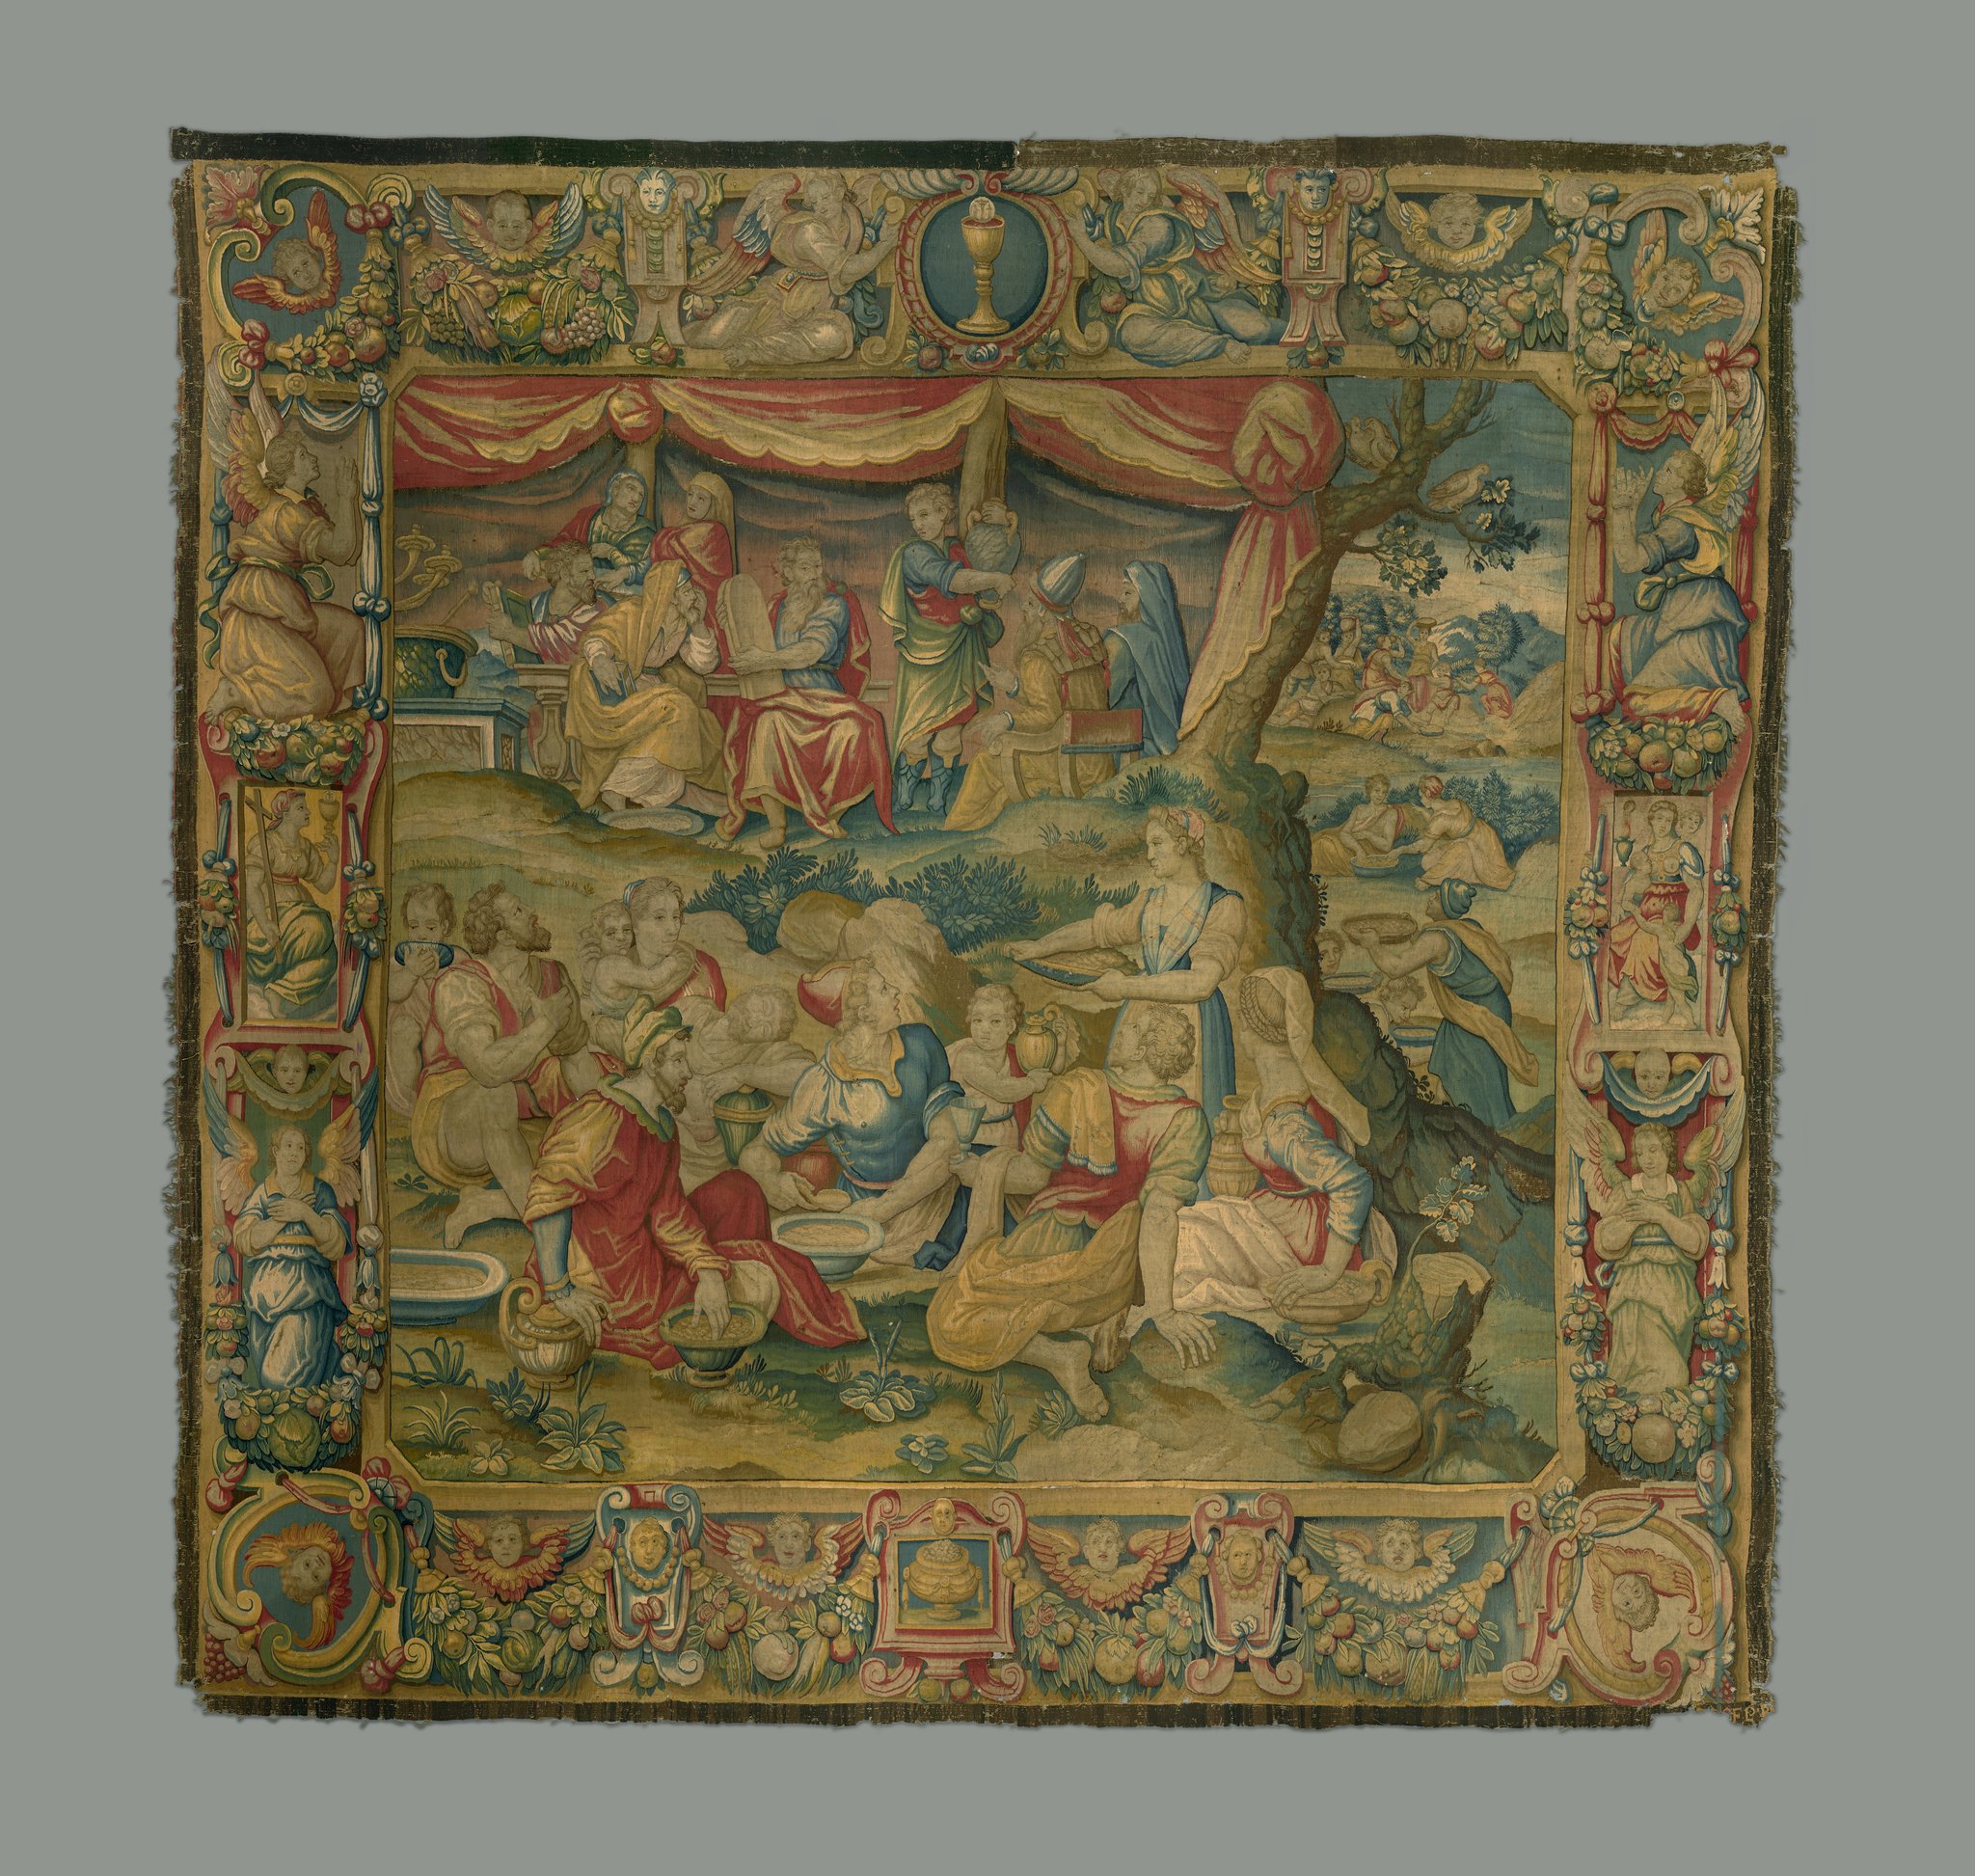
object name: tapestry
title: The Gathering of Manna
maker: alessandro allori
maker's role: designer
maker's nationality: italian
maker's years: 1535-1607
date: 1595-1596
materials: silk, wool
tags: fruit,children,men,women,putti,flowers,manna